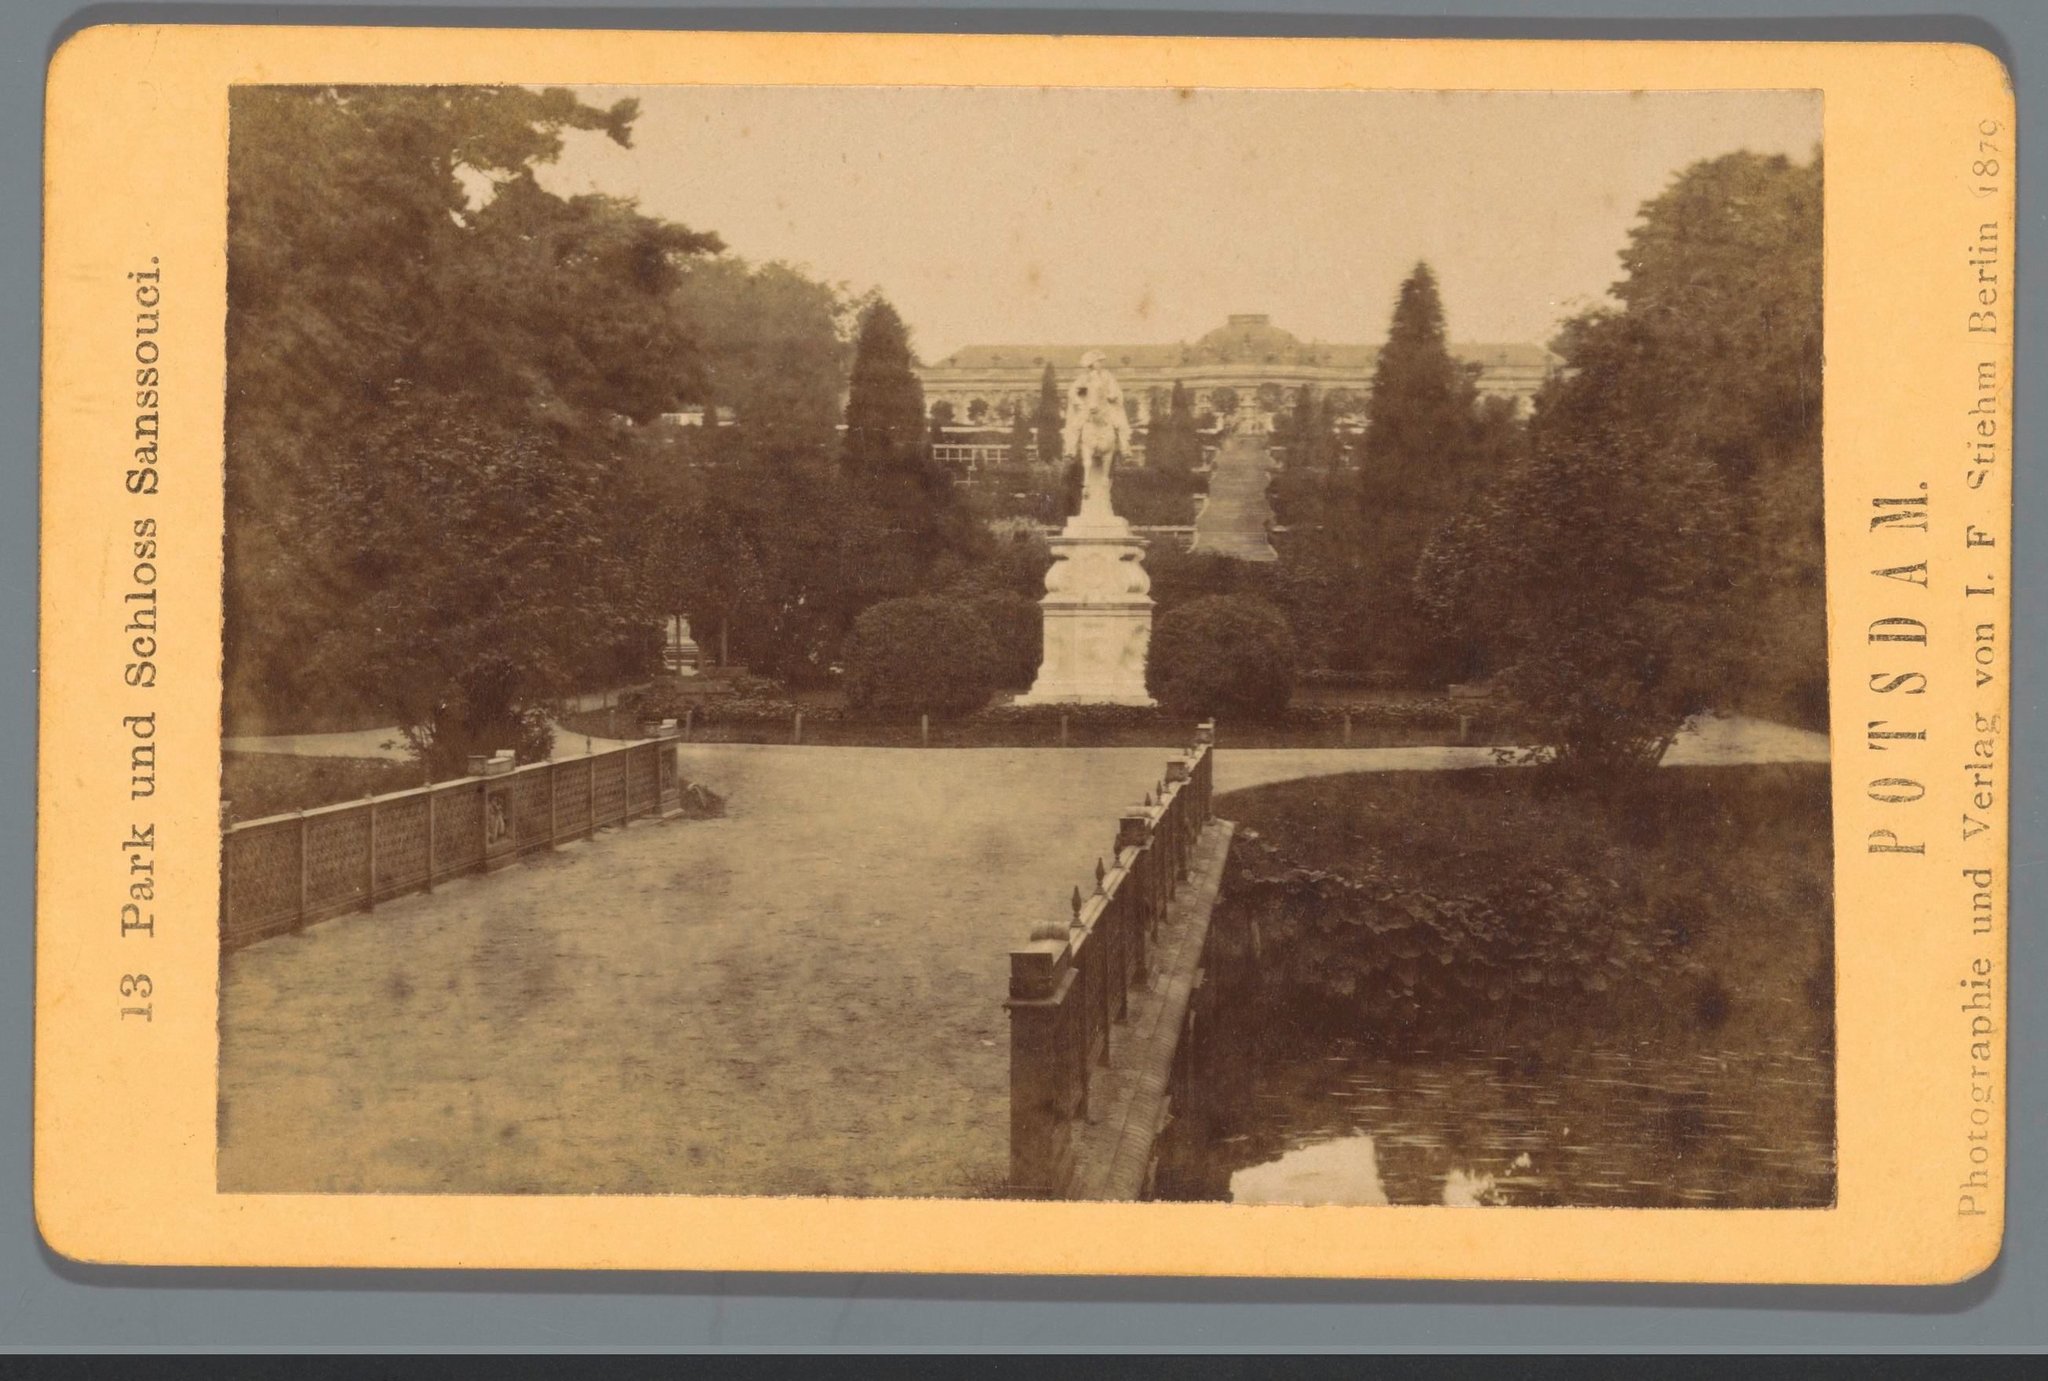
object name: photograph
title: Park Sanssouci met ruiterstandbeeld, Potsdam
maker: johann friedrich stiehm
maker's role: fotograaf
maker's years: 1826-1902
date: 1879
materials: cardboard, paper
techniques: albumen print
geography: berlin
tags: park, palace, equestrian statue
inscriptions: number: ‘13’